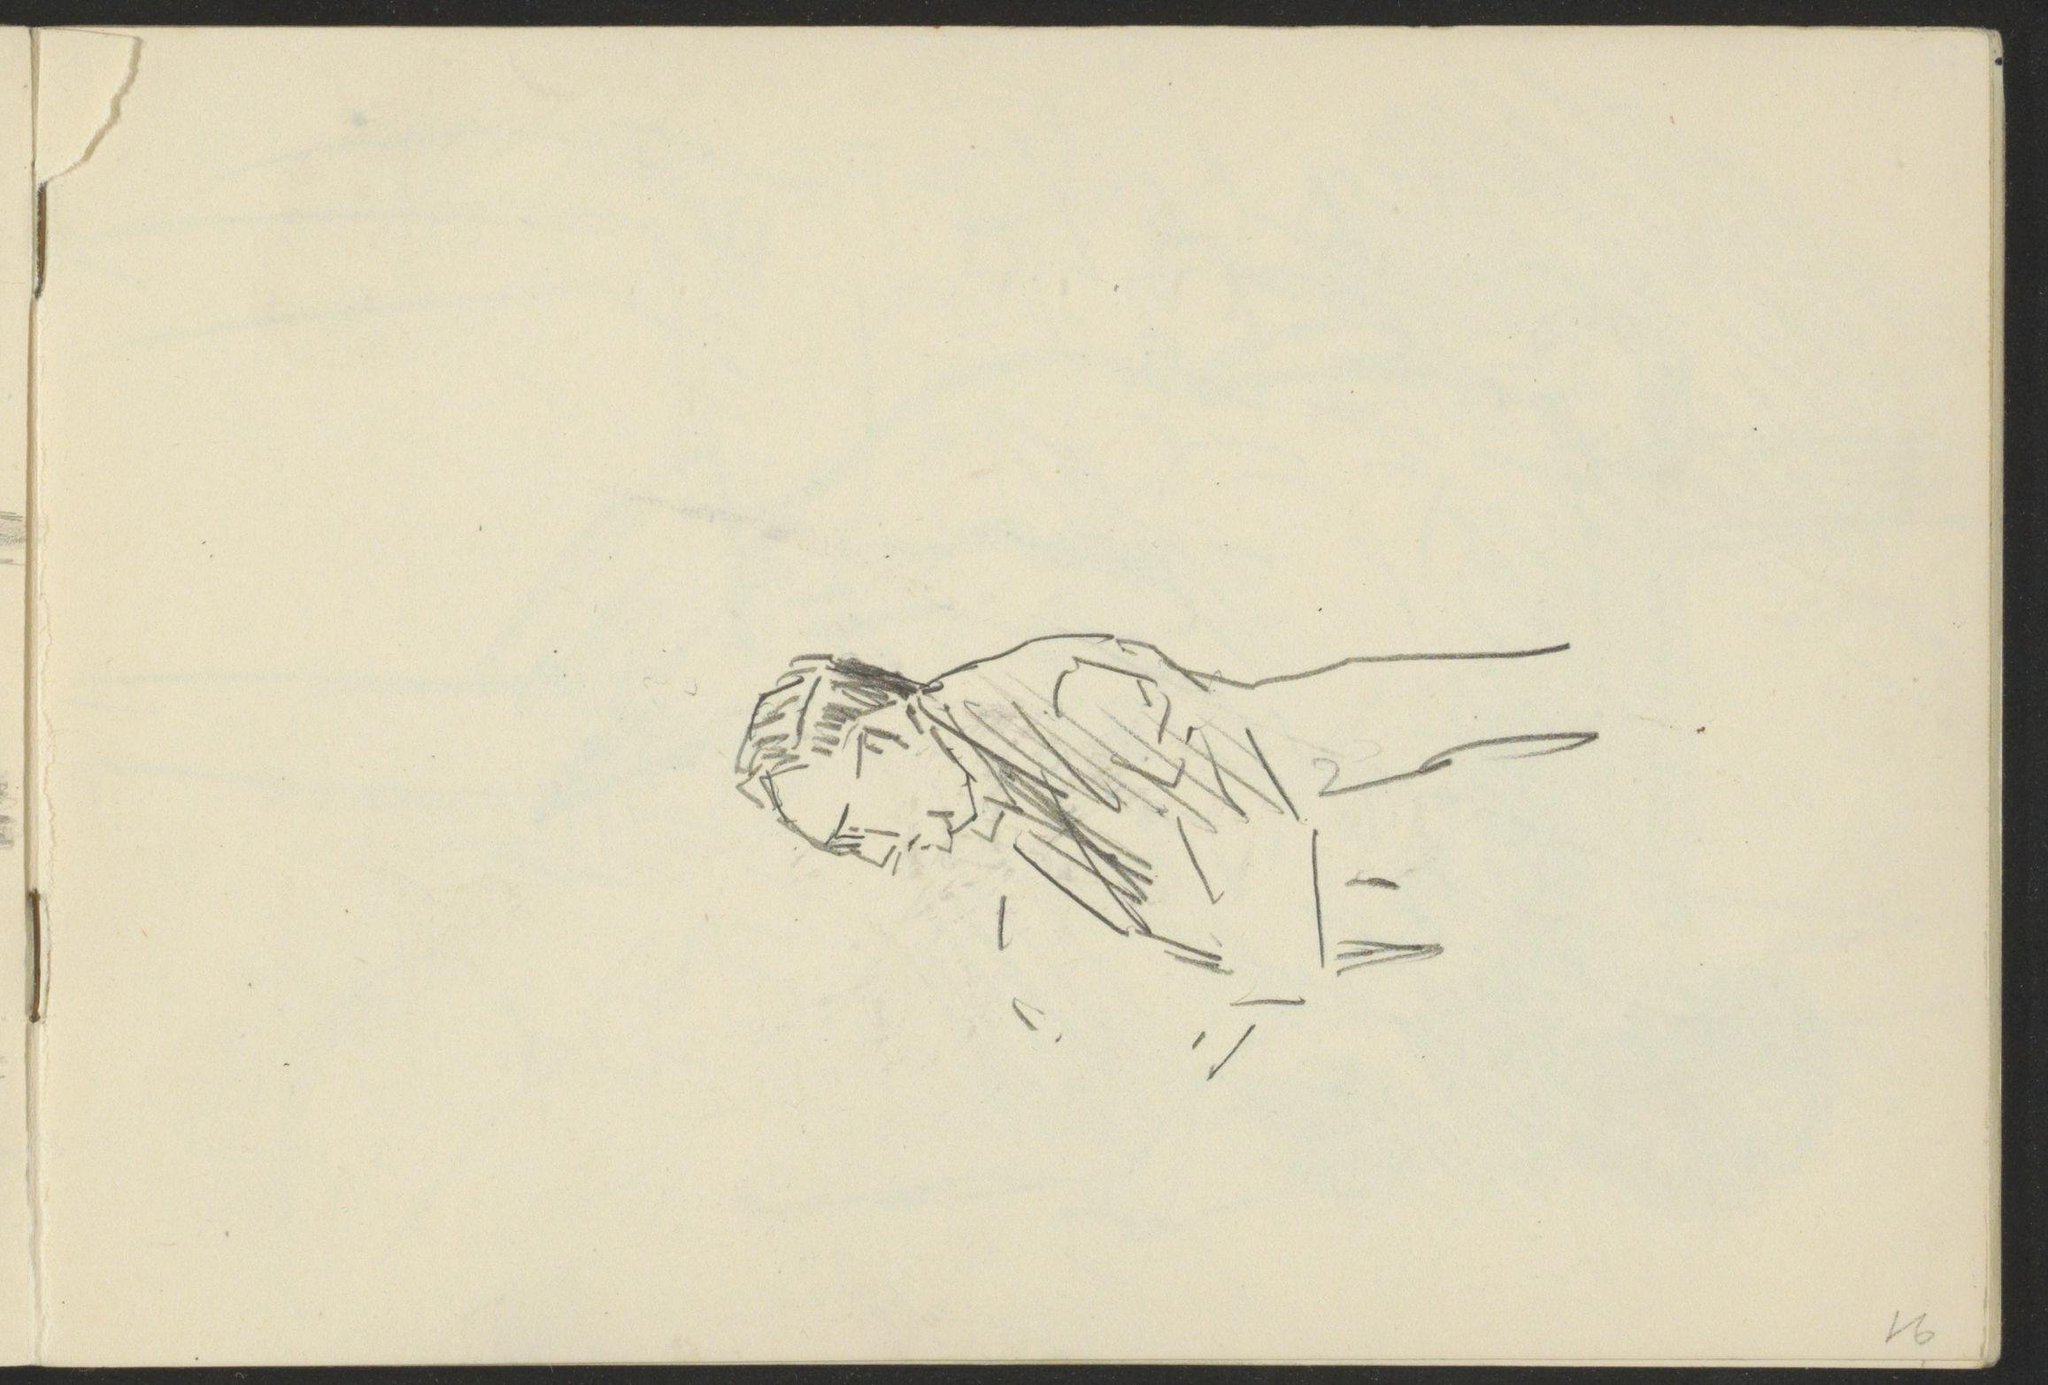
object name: sketchbook leaf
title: Staande man, in profiel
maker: isaac israels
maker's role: draughtsman, painter, print maker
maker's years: 1865-1934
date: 1875-1934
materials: paper, pencil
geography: the hague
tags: adult man (+ standing)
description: Blad 16 recto uit schetsboek LXI met 20 bladen.